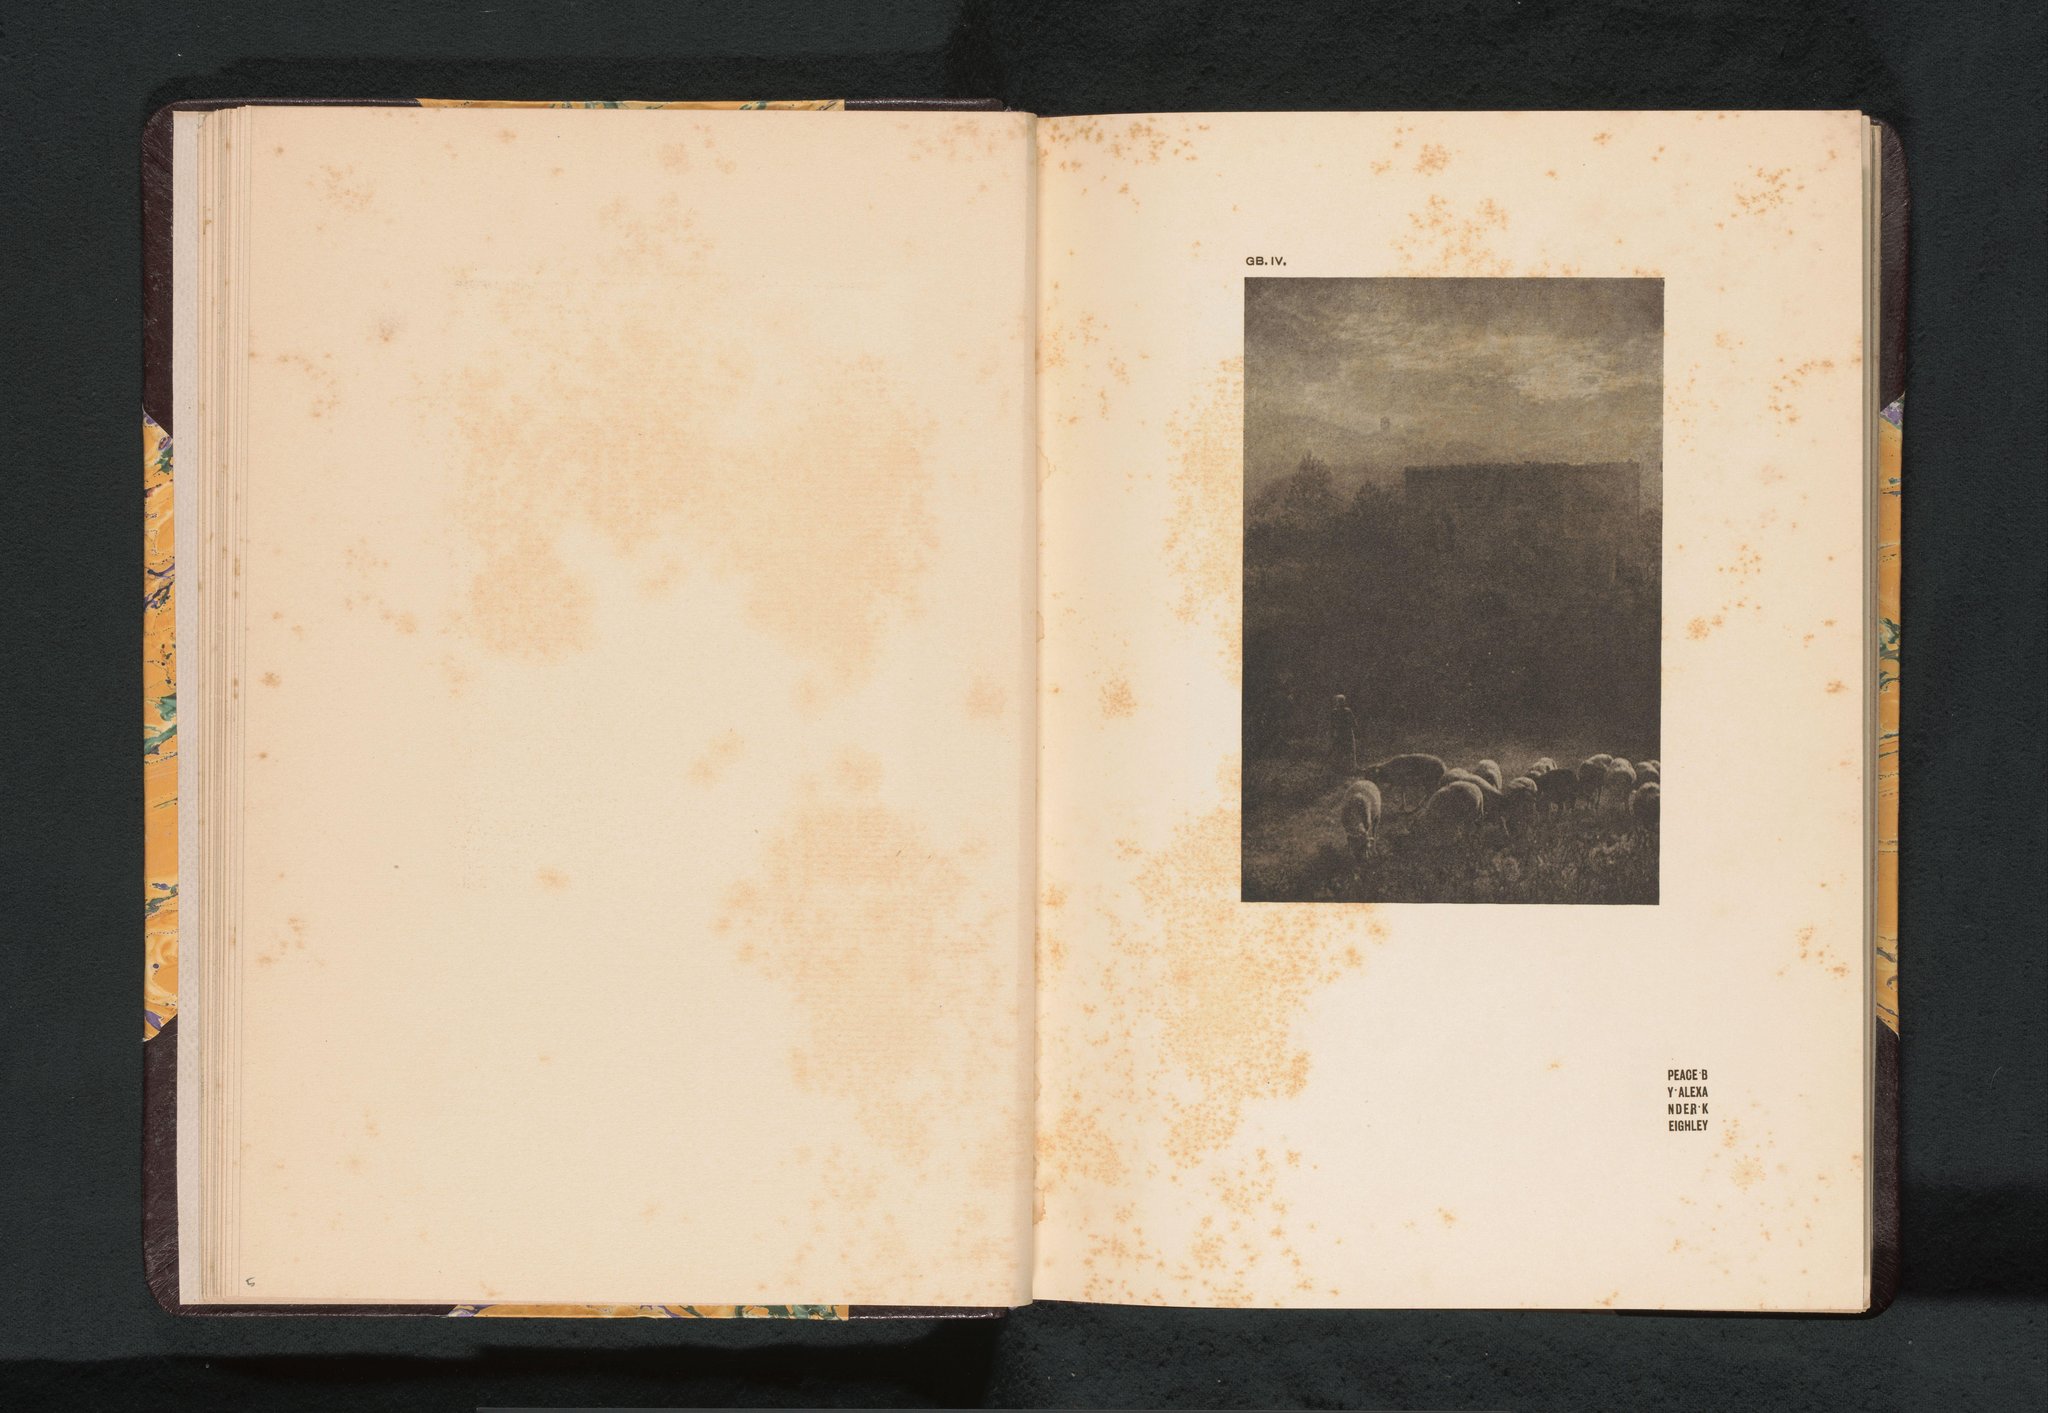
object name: page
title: Brits Landschap met schapen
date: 1900-1905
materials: paper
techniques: autotype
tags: sheep, city-view in general; 'veduta' (+ city(-scape) with figures, staffage)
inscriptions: inscription: ‘GB. IV.’, inscription: ‘Peace by Alexander Keighley’